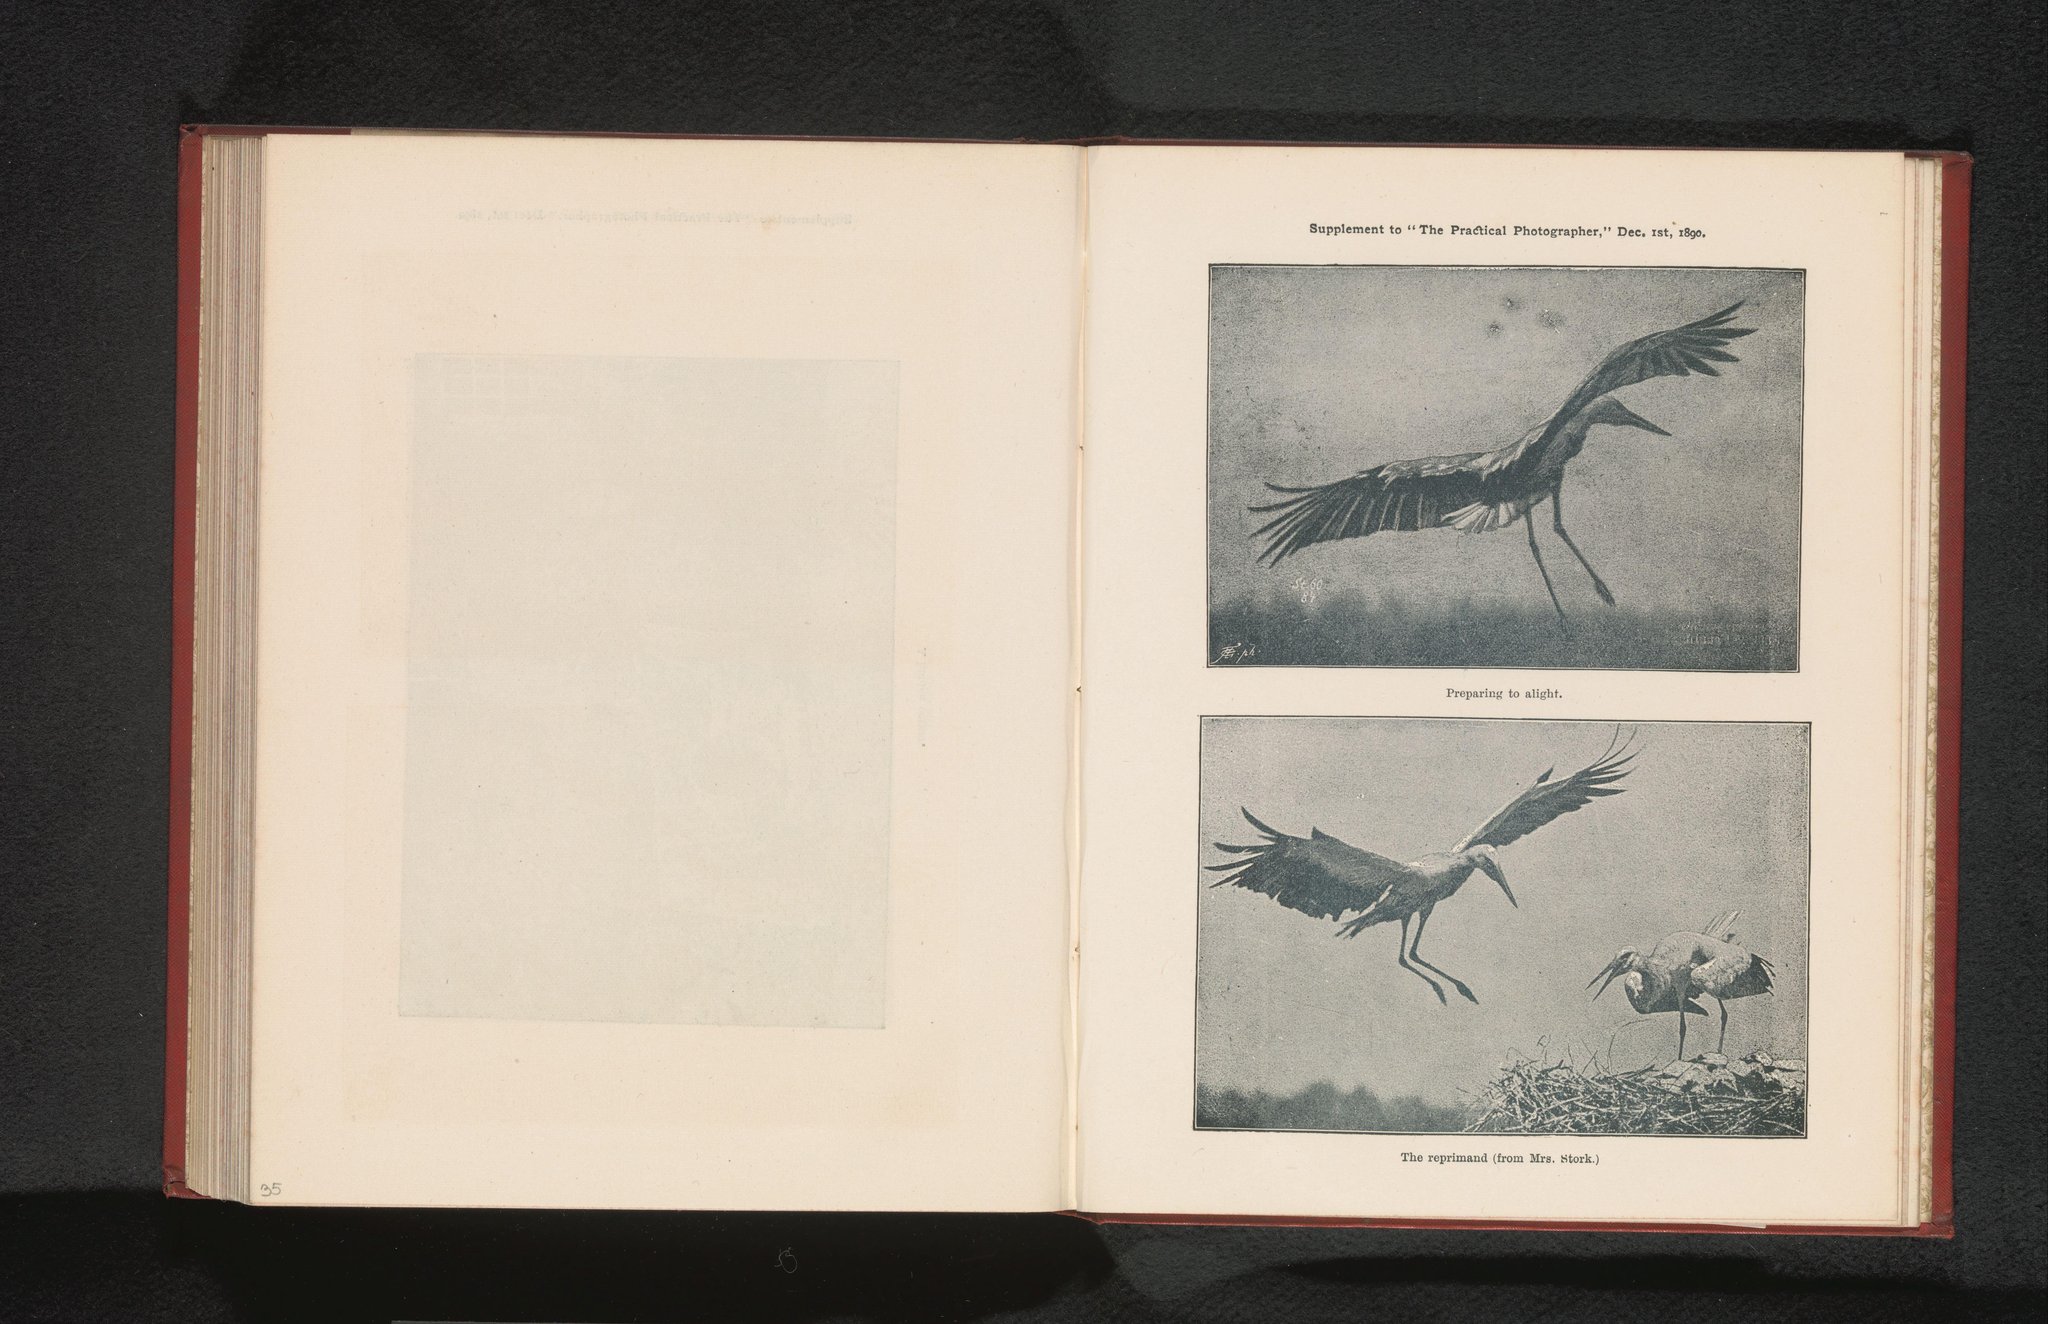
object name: photomechanical print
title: Twee stadia van de vlucht van een ooievaar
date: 1885-1890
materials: paper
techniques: autotype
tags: shore-birds and wading-birds: stork (+ animal(s) in motion; positions, expressions of animals)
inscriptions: inscription: ‘Supplement to "The Practical Photographer," Dec. 1st, 1890.’, monogram: ‘AG ph’, number: ‘St 60/ 84’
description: Prenten op negende ongenummerde pagina na pagina 294.